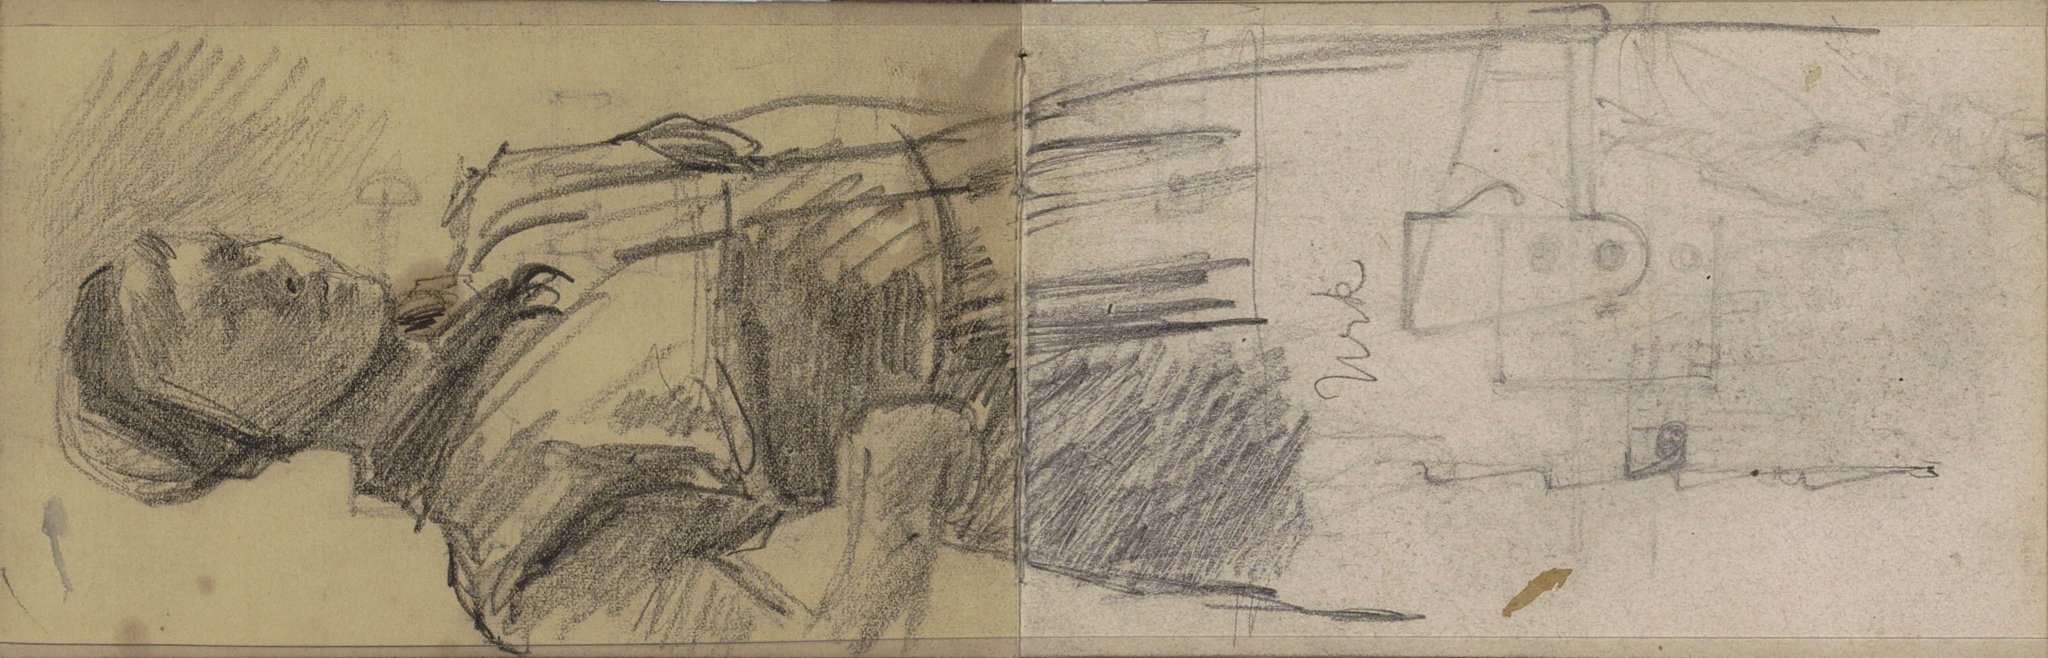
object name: sketchbook leaf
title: Jonge vrouw uit Urk met de hand in de zij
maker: george clausen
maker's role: draughtsman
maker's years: 1852-1912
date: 1875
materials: paper, pencil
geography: urk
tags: folk costume, regional costume (+ women's clothes)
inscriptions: annotation: ‘Urk’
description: Blad 30 verso en 31 recto uit een schetsboek met 38 bladen.